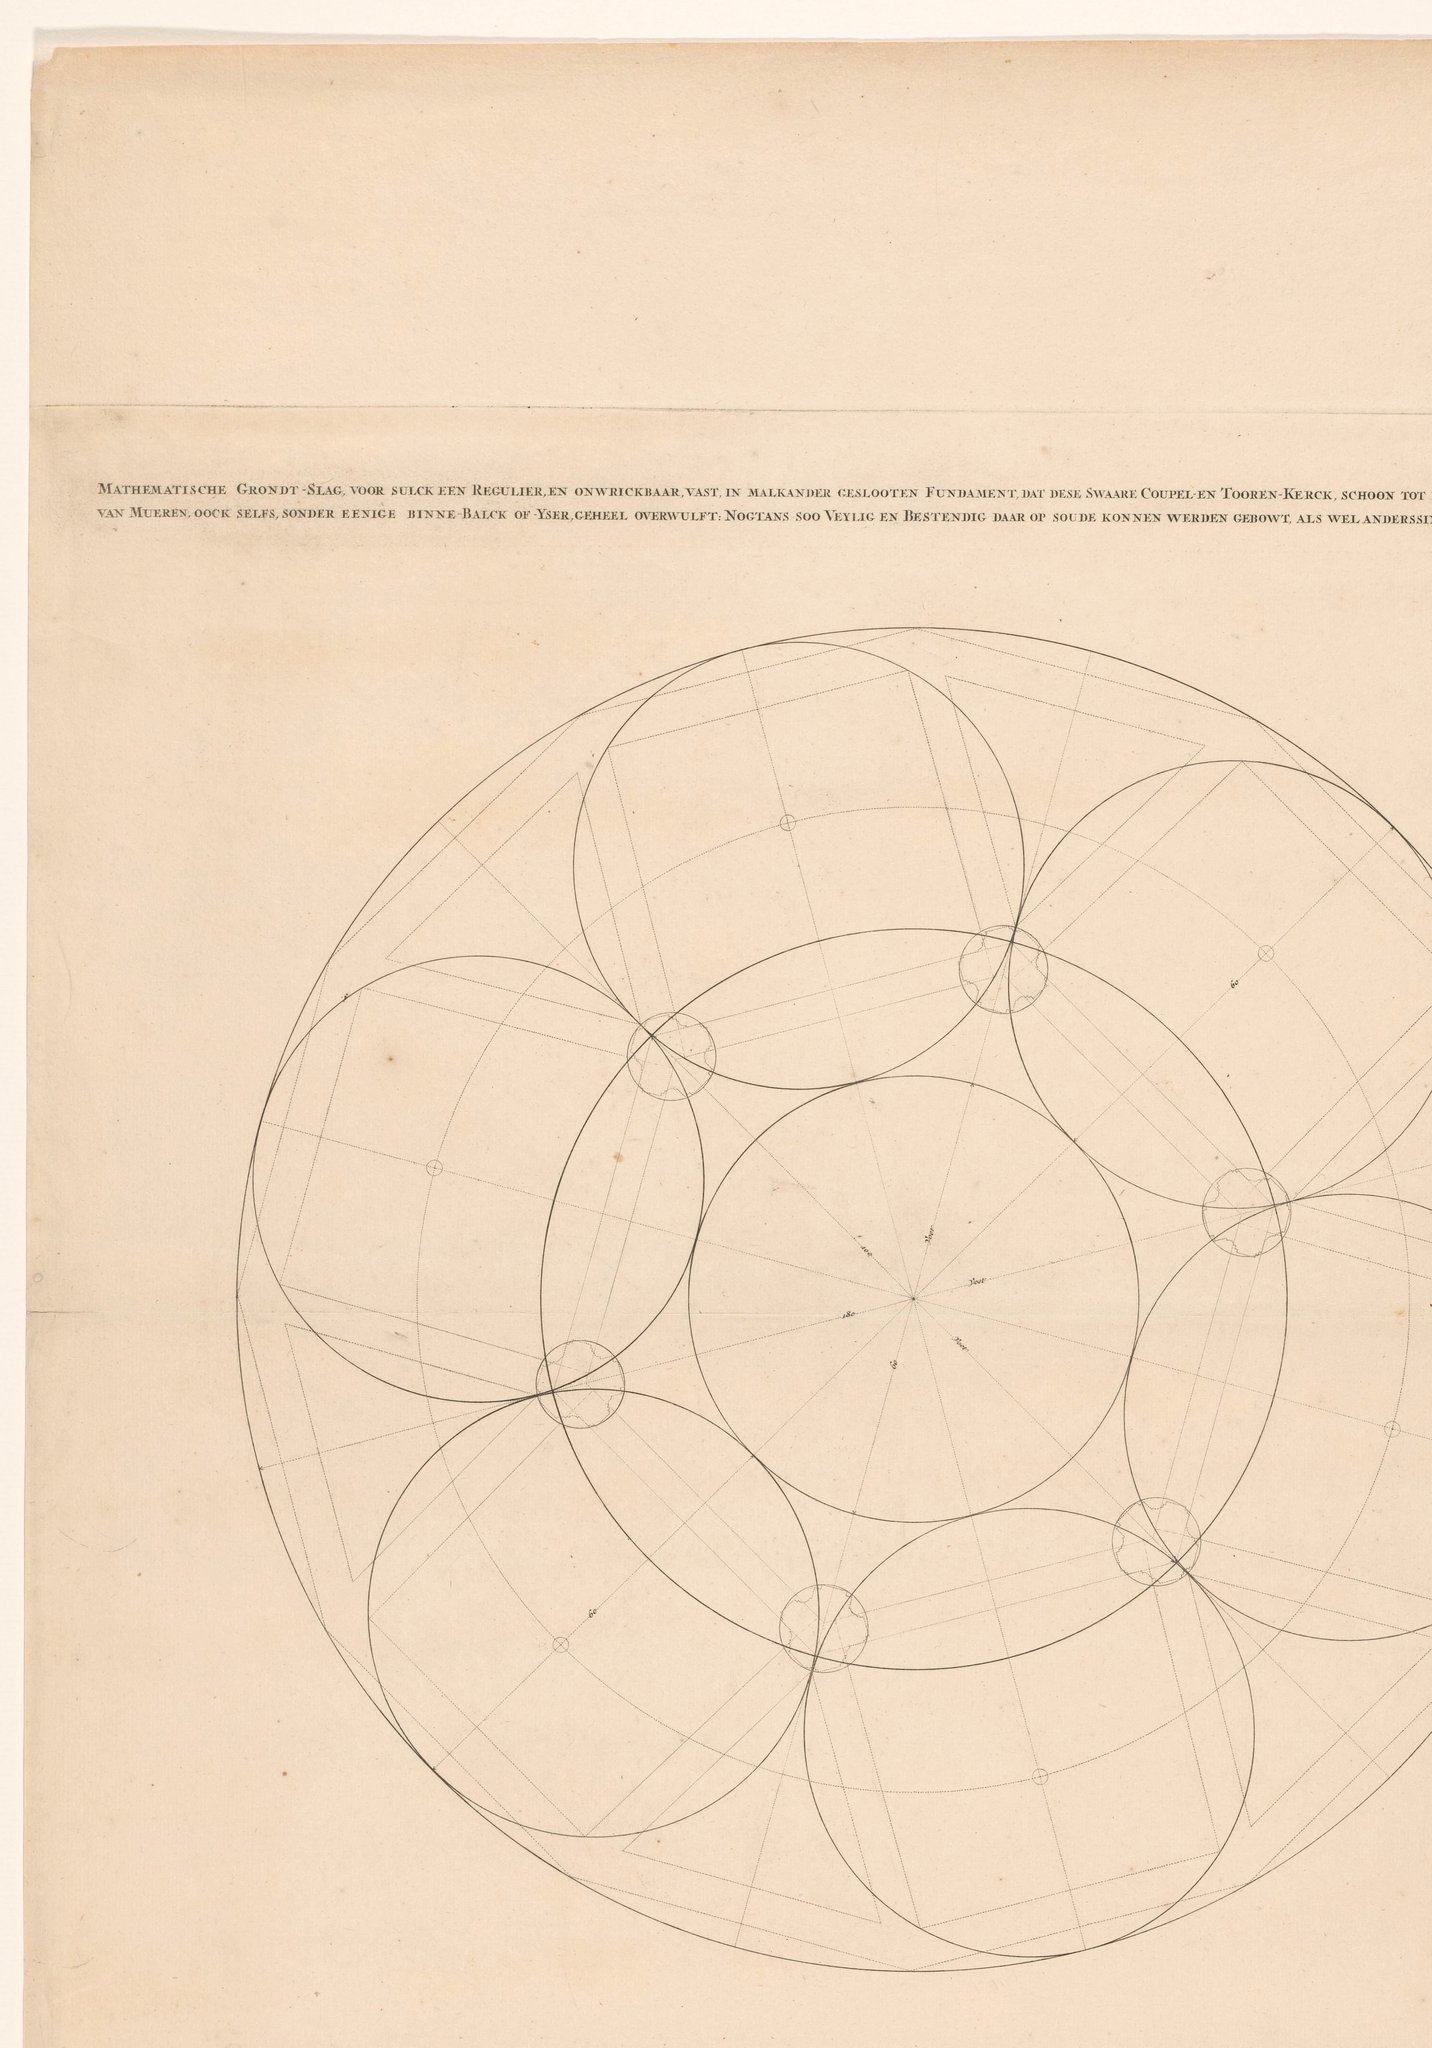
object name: print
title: Mathematische Grondt-Slag, voor sulck een Regulier, en onwrickbaar, vast, in malkander geslooten Fundament, dat dese Swaare Coupel- en Tooren-Kerck (…)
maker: daniël stopendaal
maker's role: print maker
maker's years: 1672-1726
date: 1700-1705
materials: paper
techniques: engraving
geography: amsterdam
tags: church (exterior), interior of church, plan ~ architecture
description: Notaris, advocaat en kerkmeester van de Oude Kerk Nicolaas Listingh maakte rond 1700 een ontwerp voor een nieuwe koepelkerk op de Botermarkt (het huidige Rembrandtplein). Naast een houten maquette, die nog steeds te zien is in de Oude Kerk, liet hij ook op eigen kosten een serie van zeventien prenten van zijn ontwerp maken ('Nievv desseyn tot een Seer Groote, Stercke, en om te hooren, heel bequame Coupel-Kerck (…)'). De huidige prent is daar onderdeel van. Deze prenten zouden zijn gemaakt door Daniël Stopendaal.* *Long, Isaac le. Historische beschryvinge van de reformatie der stadt Amsterdam (…). Amsterdam: Johannes van Septeren (I), 1729, p. 572.